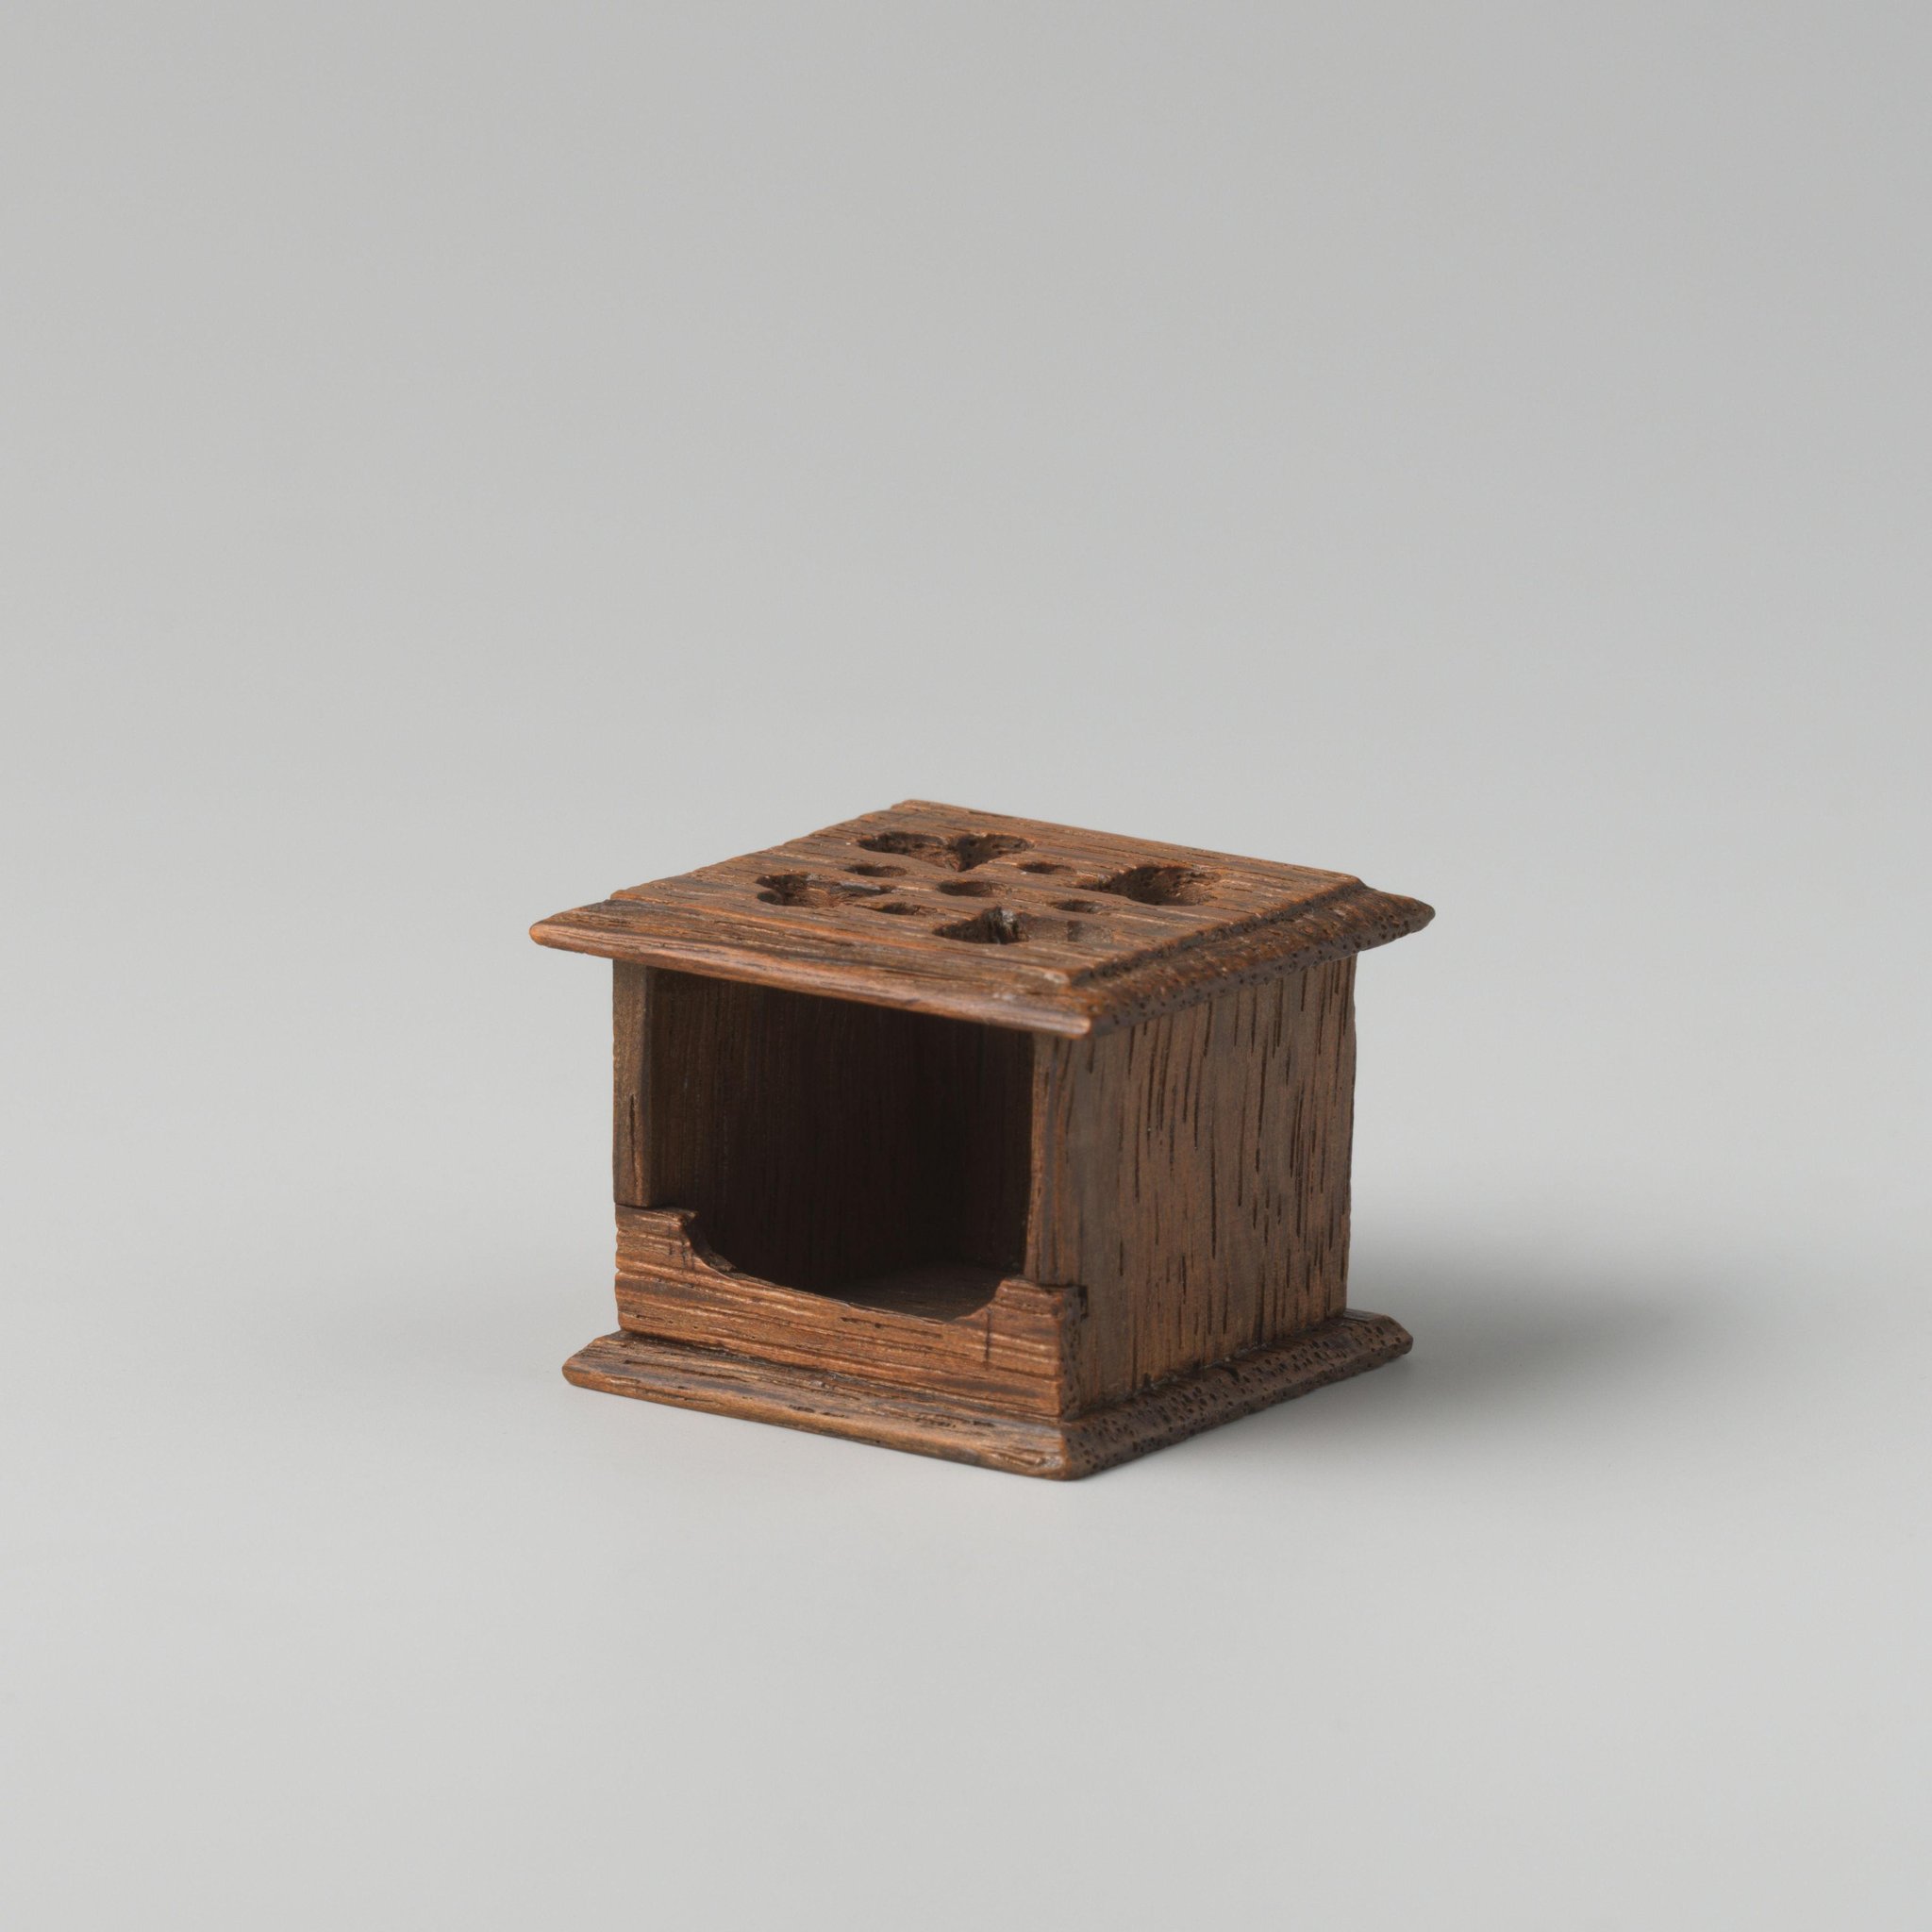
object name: miniature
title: Vierkante stoof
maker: Anonymous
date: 1690-1710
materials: wood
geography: amsterdam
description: Vierkante stoof van eikenhout. De stoof heeft een opstaande rand aan de voorzijde en in de voetenplank zijn vier hartvormige en vijf ronde gaten aangebracht.